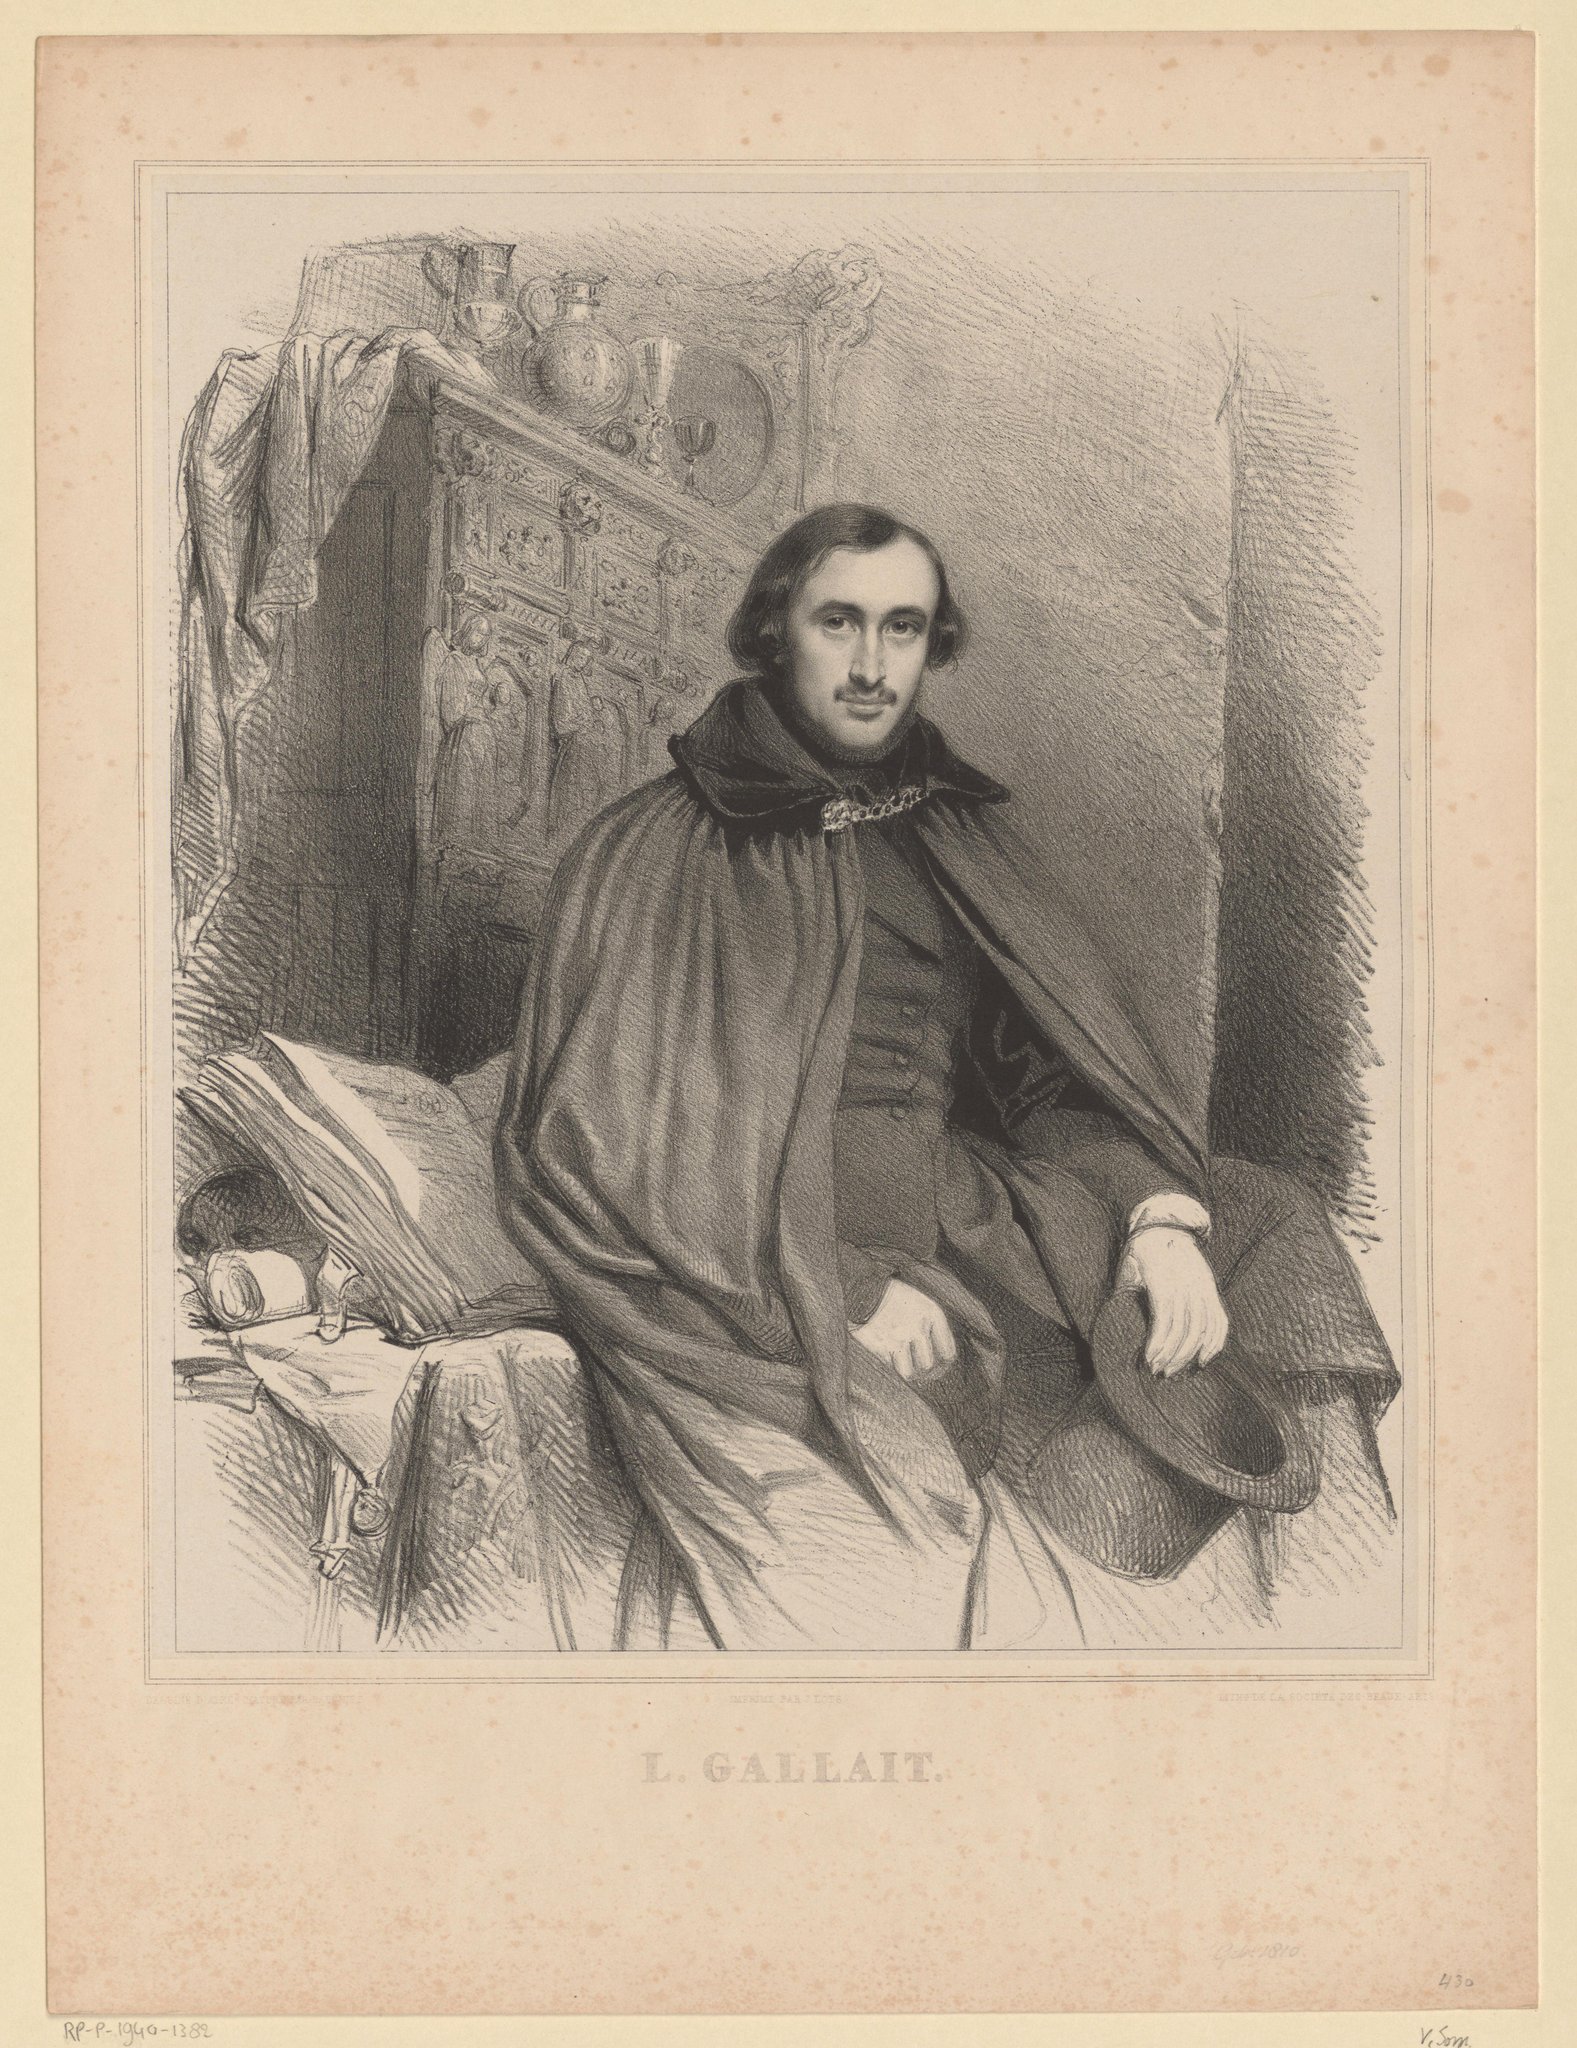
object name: print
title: Portret van Louis Gallait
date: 1836-1840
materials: paper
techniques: lithograph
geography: brussels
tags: painter, print maker, draughtsman, louis gallait, historical persons, portrait, self-portrait of painter, head-gear: top hat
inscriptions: collector's mark: Lugt 2166, collector's mark: Lugt 2760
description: Andere staat verschenen in: Baugniet, Charles. Les artistes contemporains: portraits lithographiés d'après nature, accompagnés de notices sur la vie et les ouvrages de chacun d'eux. Brussel: De Wasme-Pletinckx, [1836-1840].